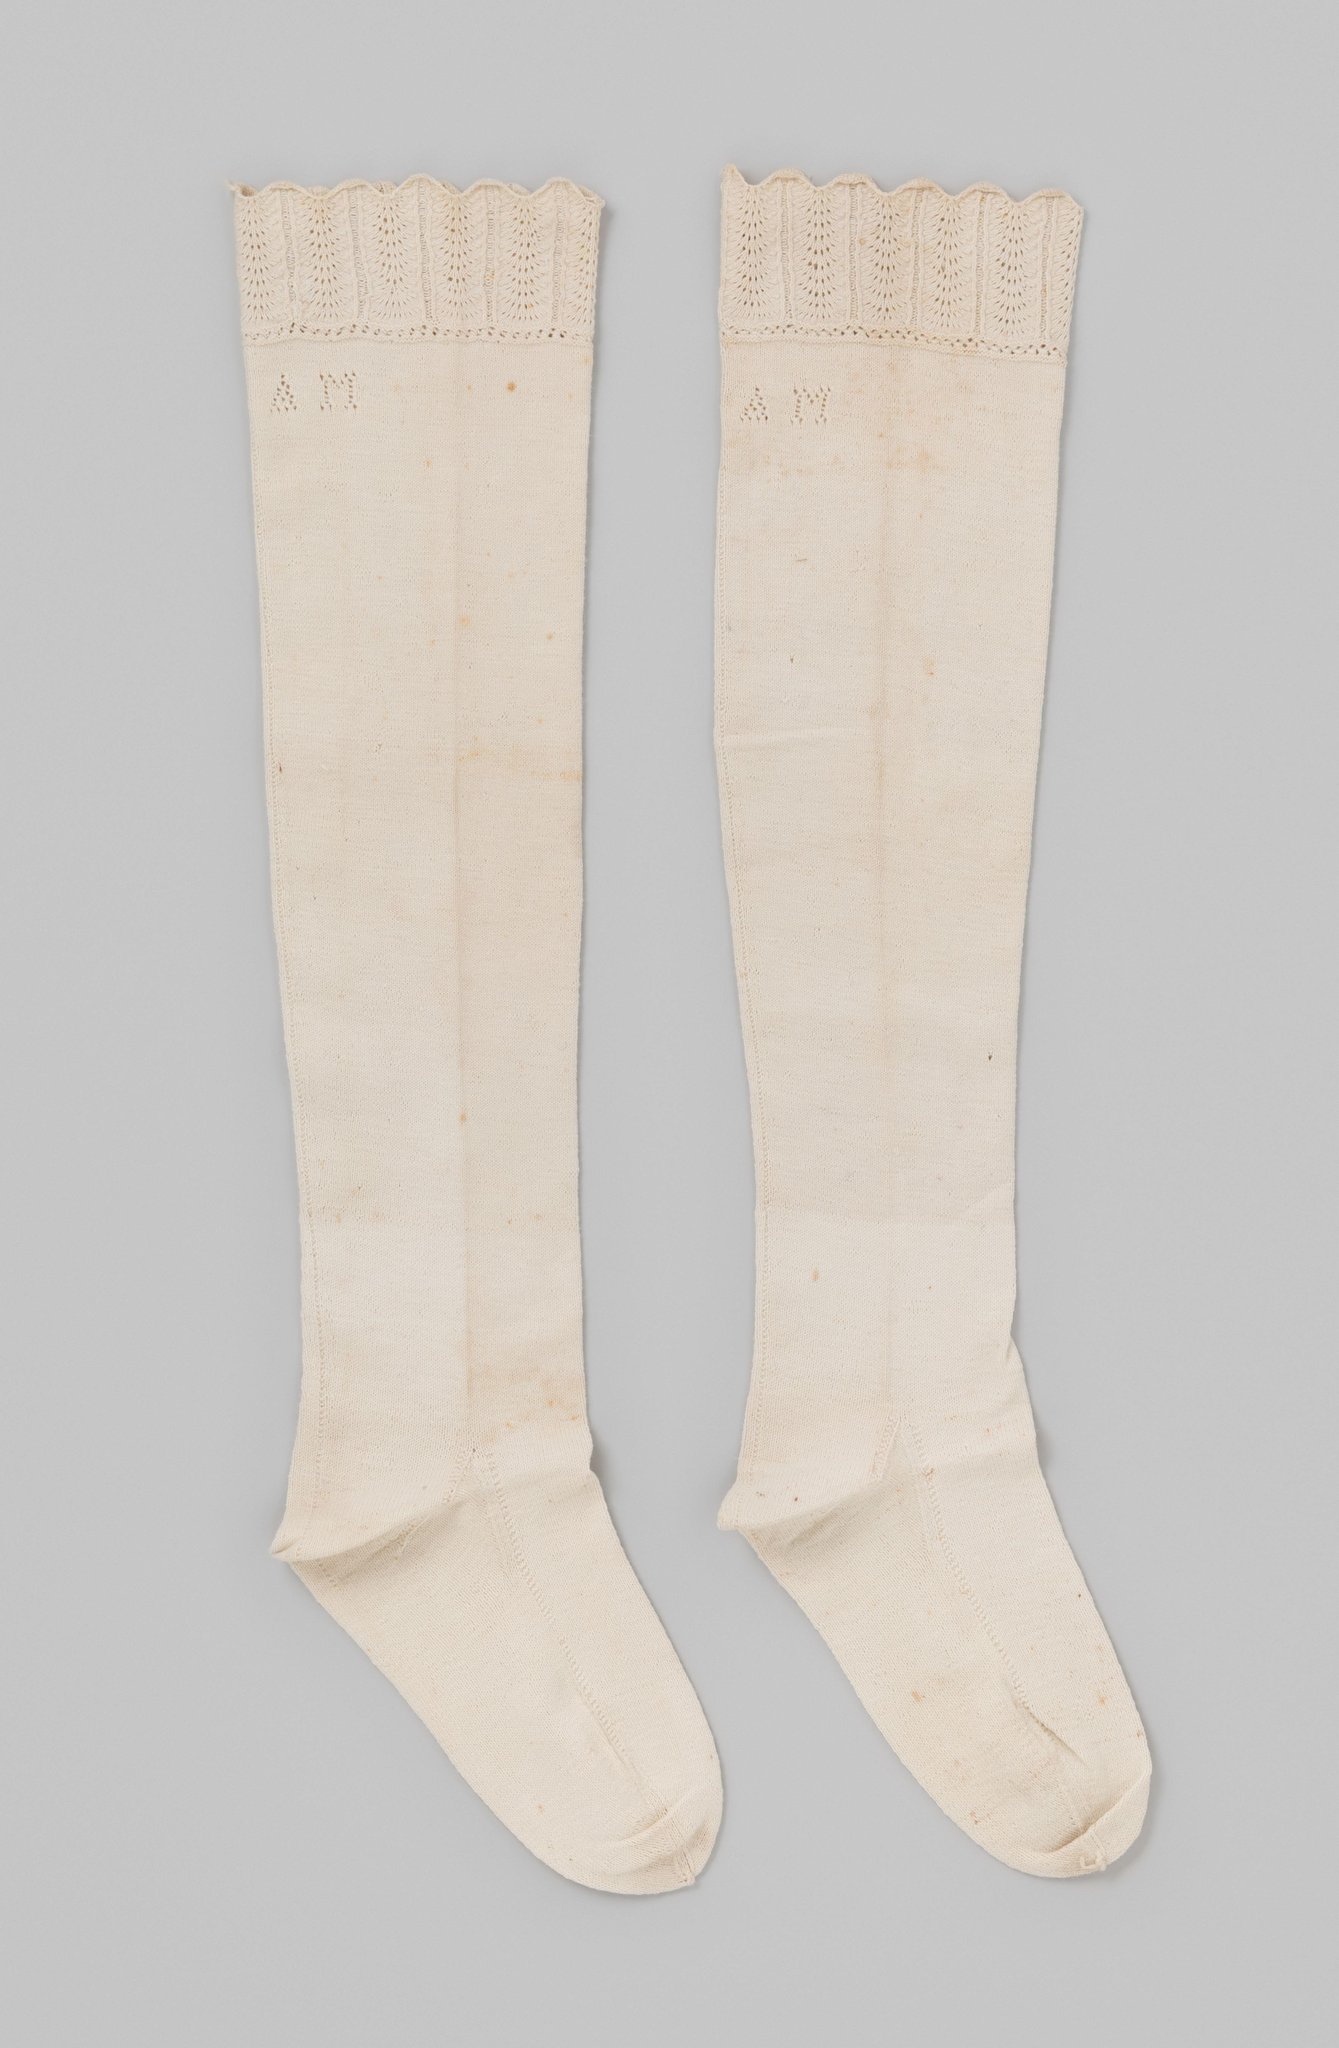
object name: stocking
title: Kous van effen witte katoenen tricot, met boord van ajour pauwenverenmotief en geschulpte rand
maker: Anonymous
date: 1830-1840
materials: cotton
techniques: embroidery, knitting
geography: netherlands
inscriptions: initials: ‘'A M'’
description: Kous van effen witte katoenen tricot, met boord van ajour pauwenverenmotief in verticale banen en geschulpte rand. Naad middenachter. Gemerkt met initialen in ajour: 'A M'.